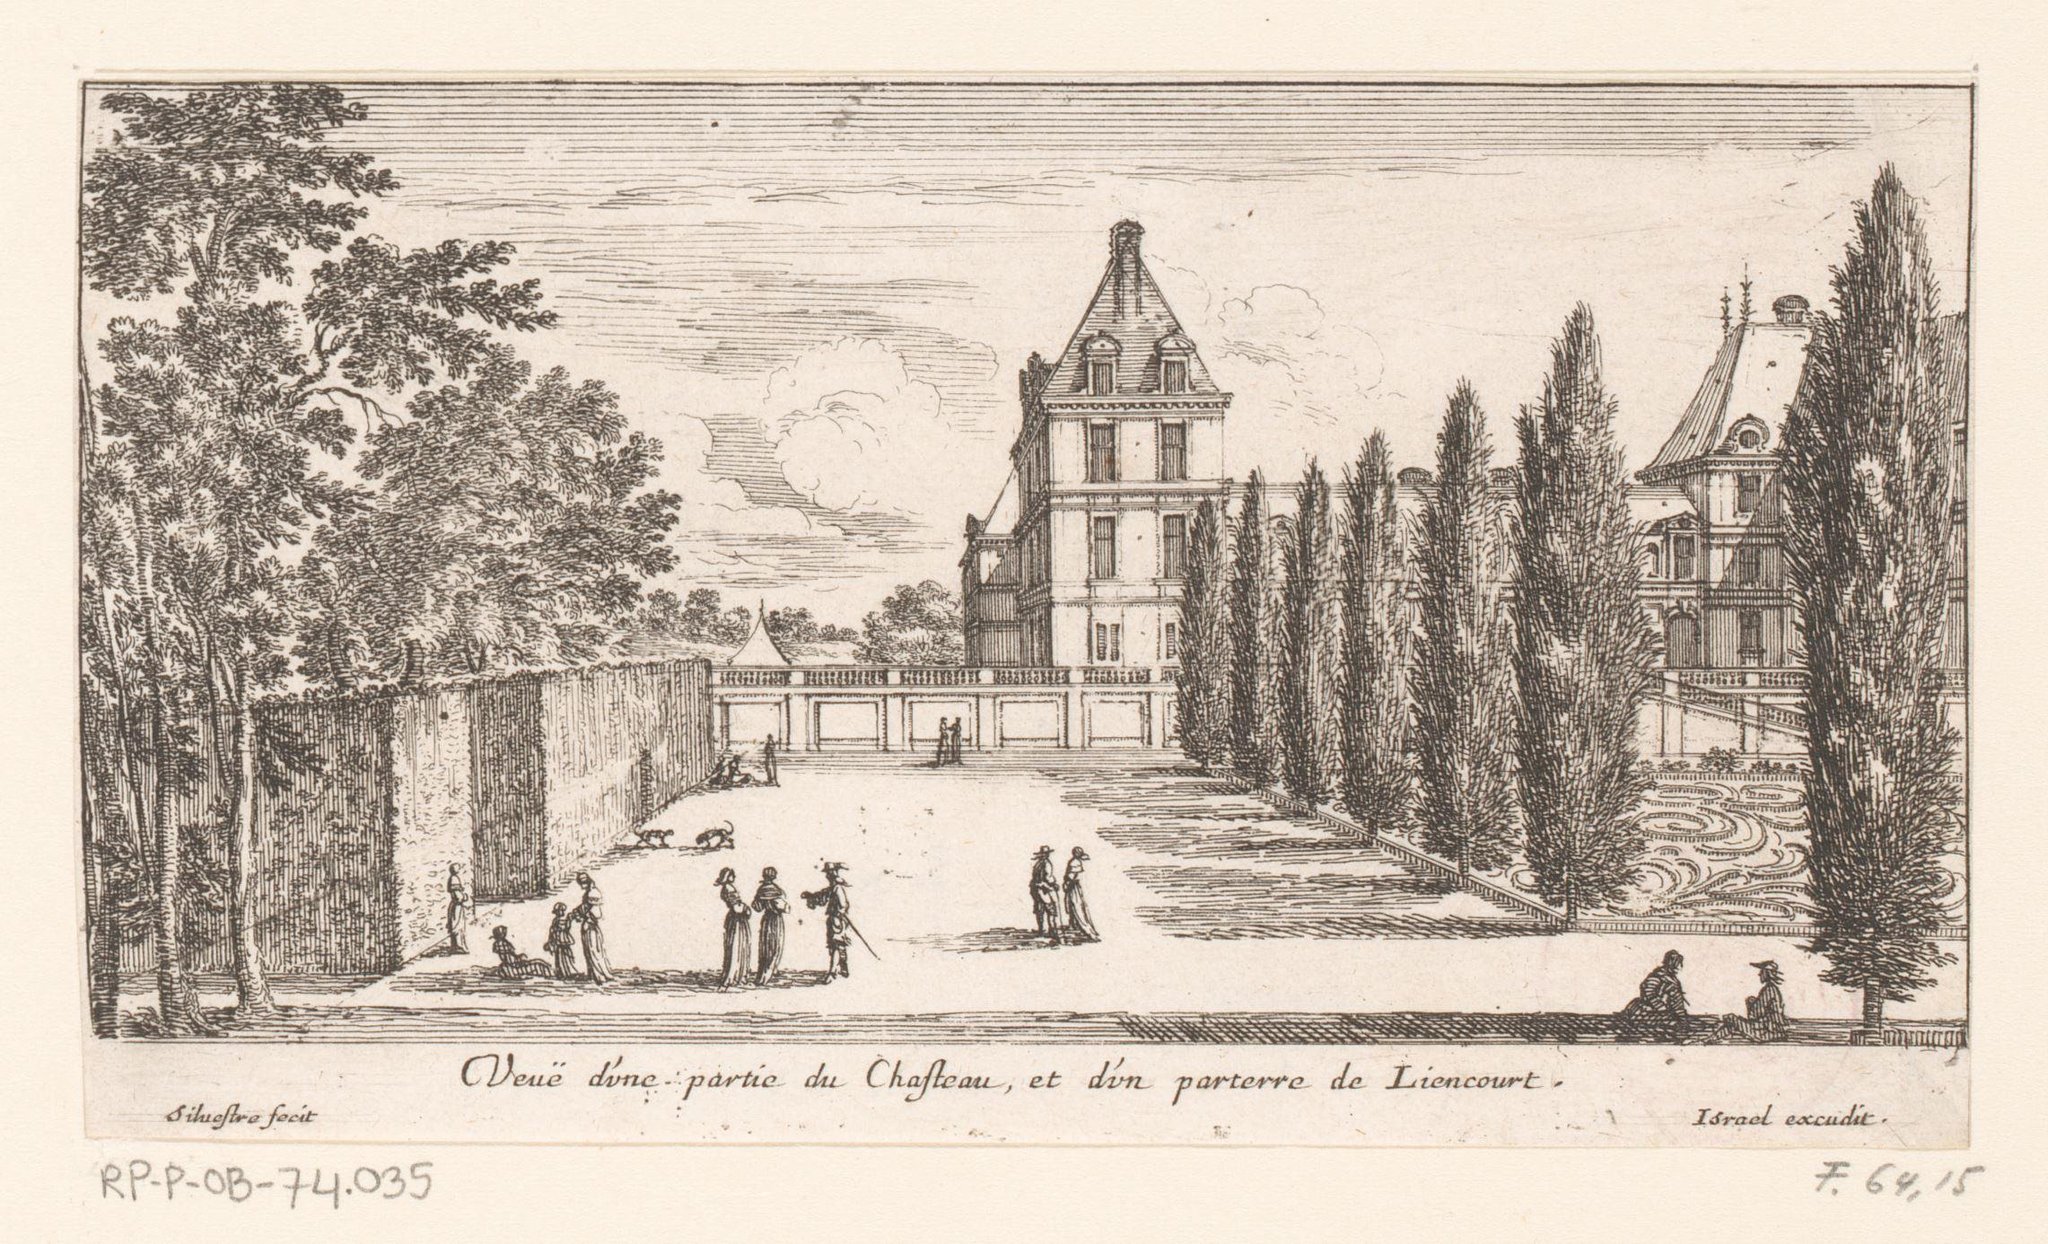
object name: print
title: Veue d'une partie du Chasteau en d'un parterre de Liencourt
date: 1652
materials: paper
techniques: engraving, etching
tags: city-view, and landscape with man-made constructions, paris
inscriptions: collector's mark: Lugt 240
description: Prent maakt deel uit van een ongenummerde serie van 30 prenten.